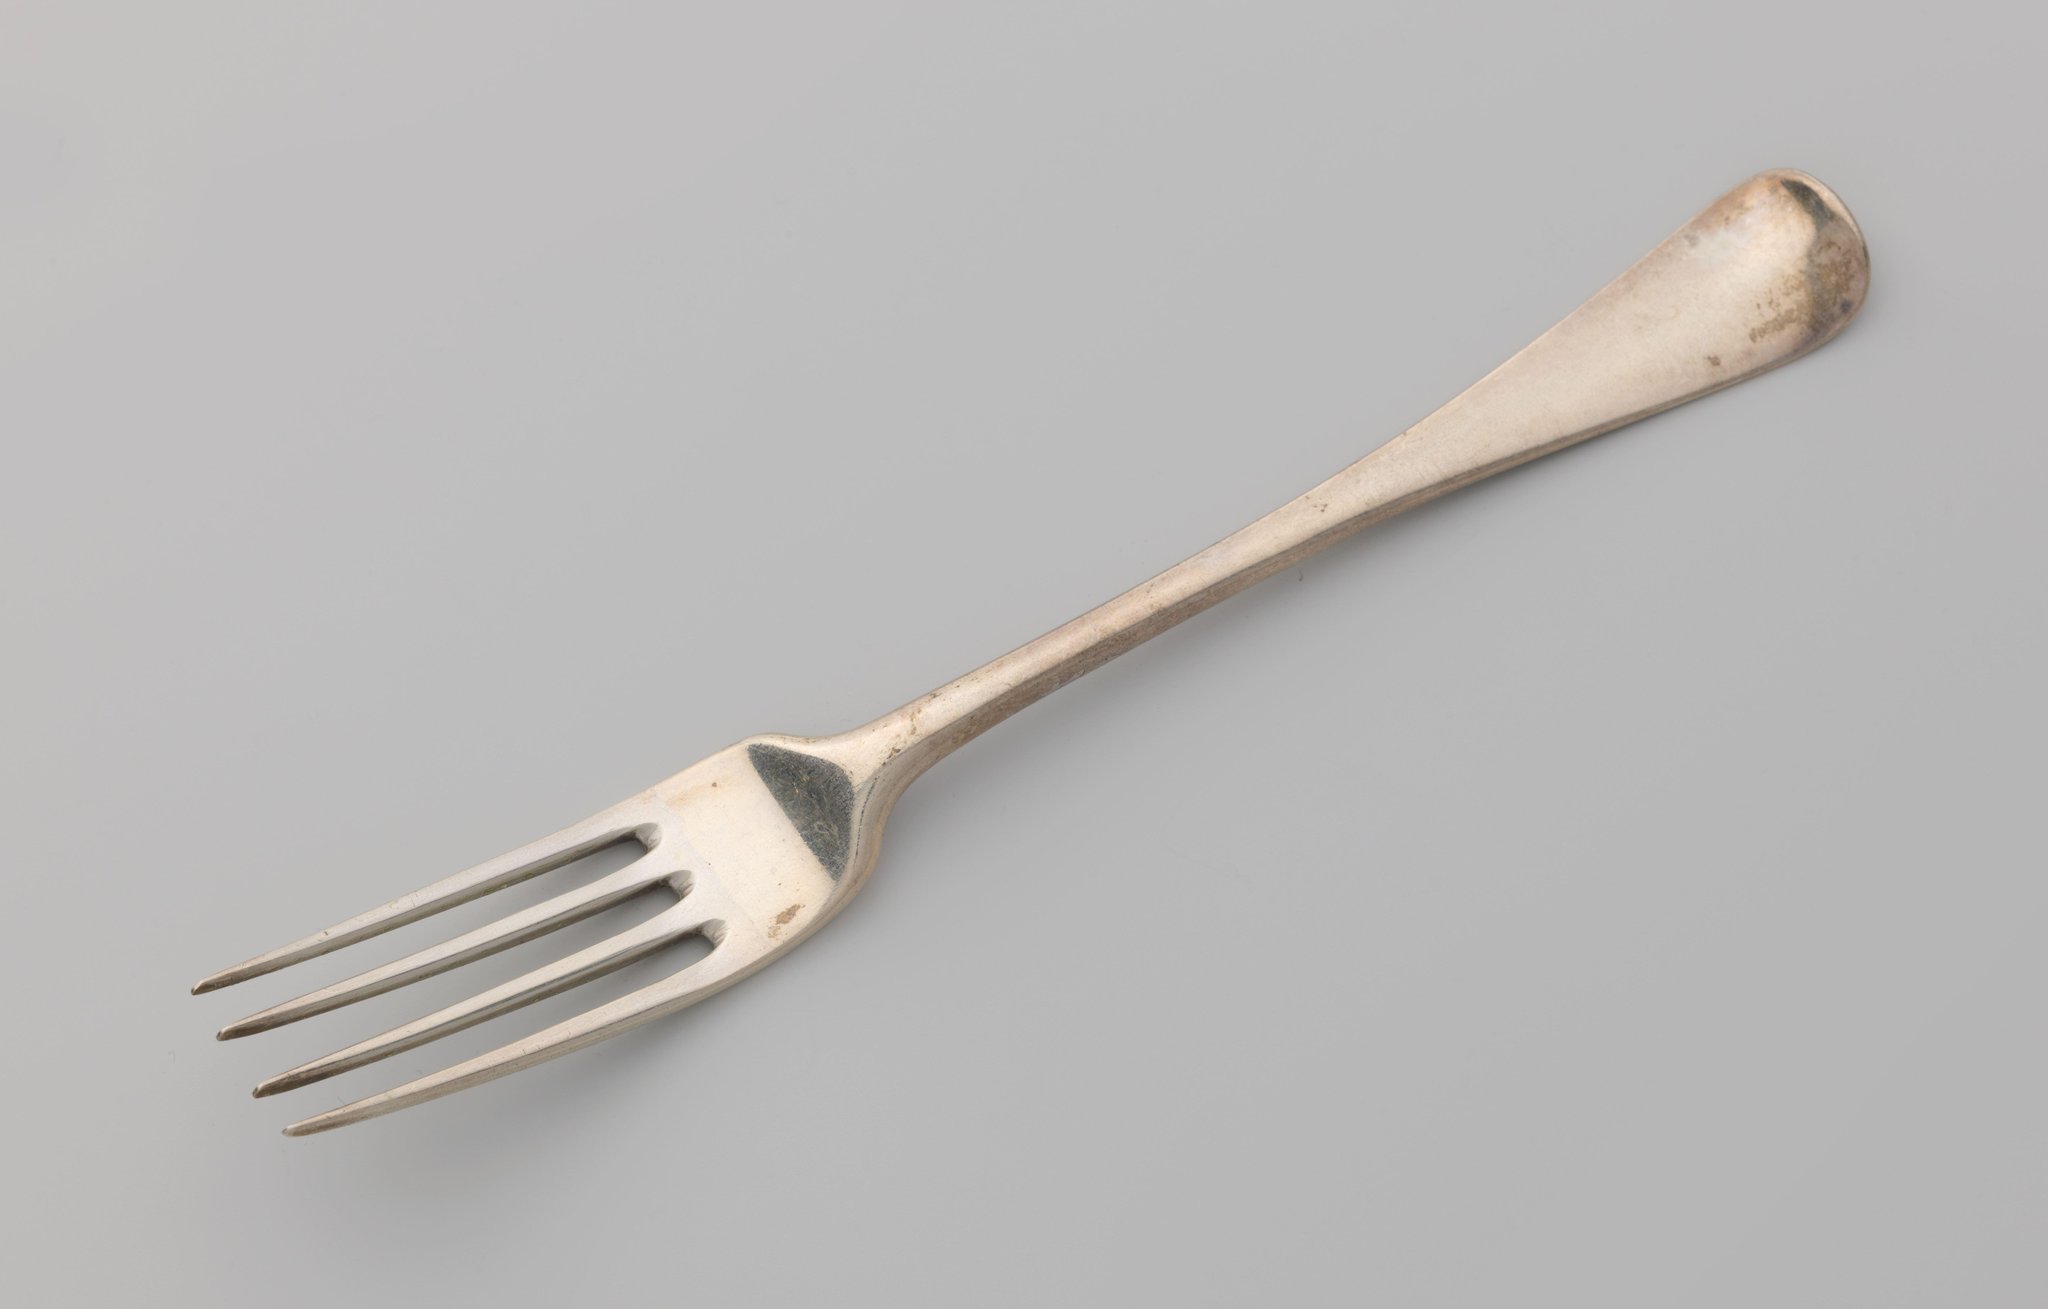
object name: fork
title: Vork van zilver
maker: dirk van gameren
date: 1764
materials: silver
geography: utrecht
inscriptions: mark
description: Vork van zilver, met 4 tanden. De vork gaat geleidelijk over in de platte steel die zich verbreedt naar het afgeronde uiteinde.